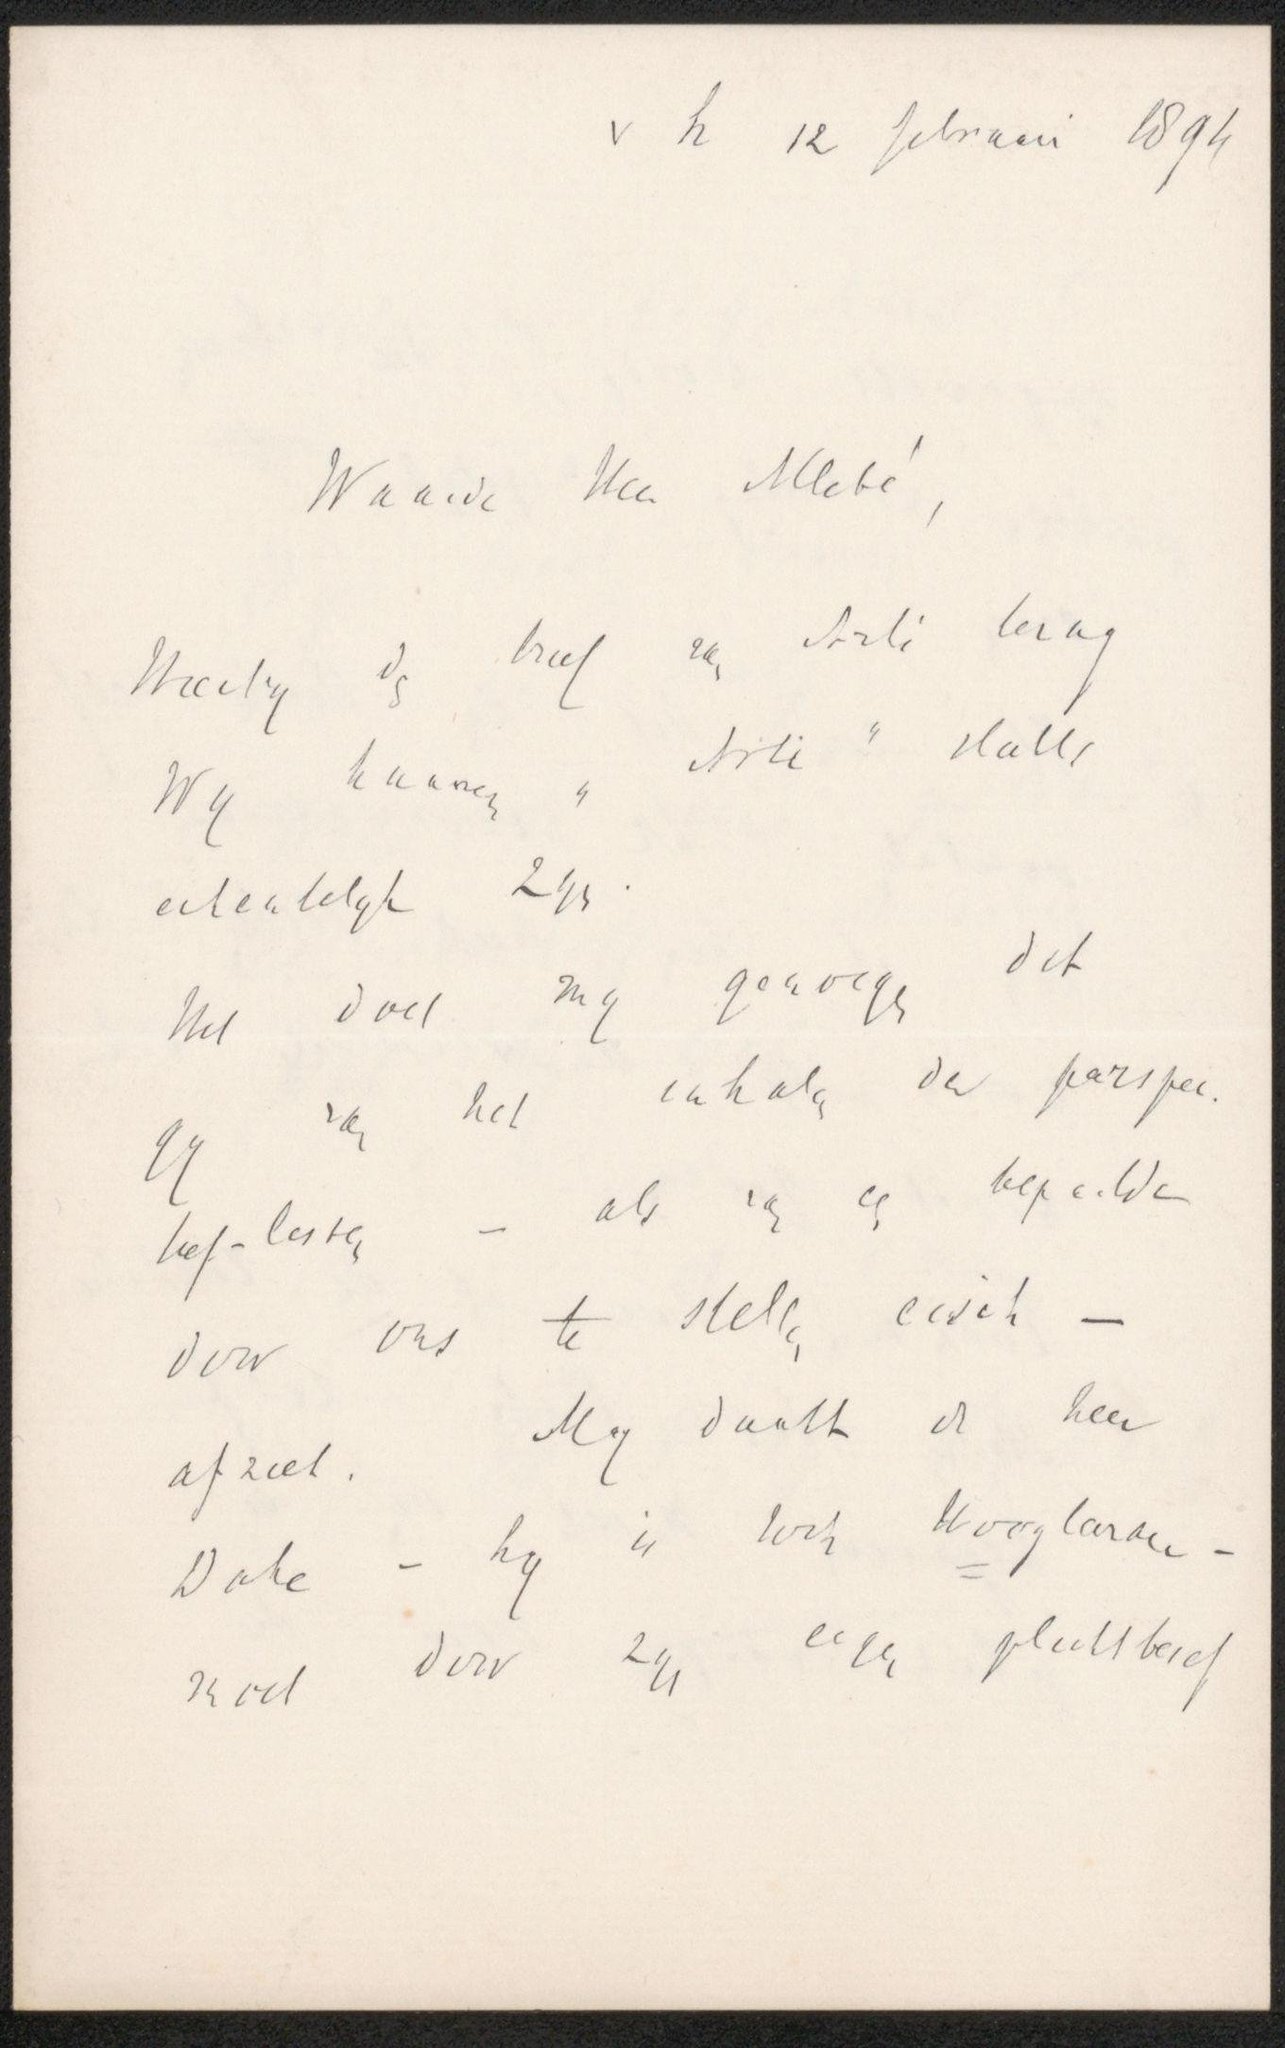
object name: letter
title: Brief aan August Allebé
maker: hendrick peter godfried quack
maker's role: econoom, geschiedschrijver, hoogleraar, jurist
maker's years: 1834-1917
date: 1894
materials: ink, paper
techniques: pen, writing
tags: august allebé, painter, carel lodewijk dake, print maker, ferdinand leenhoff, education, tuition of the artist (in general)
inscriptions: watermark